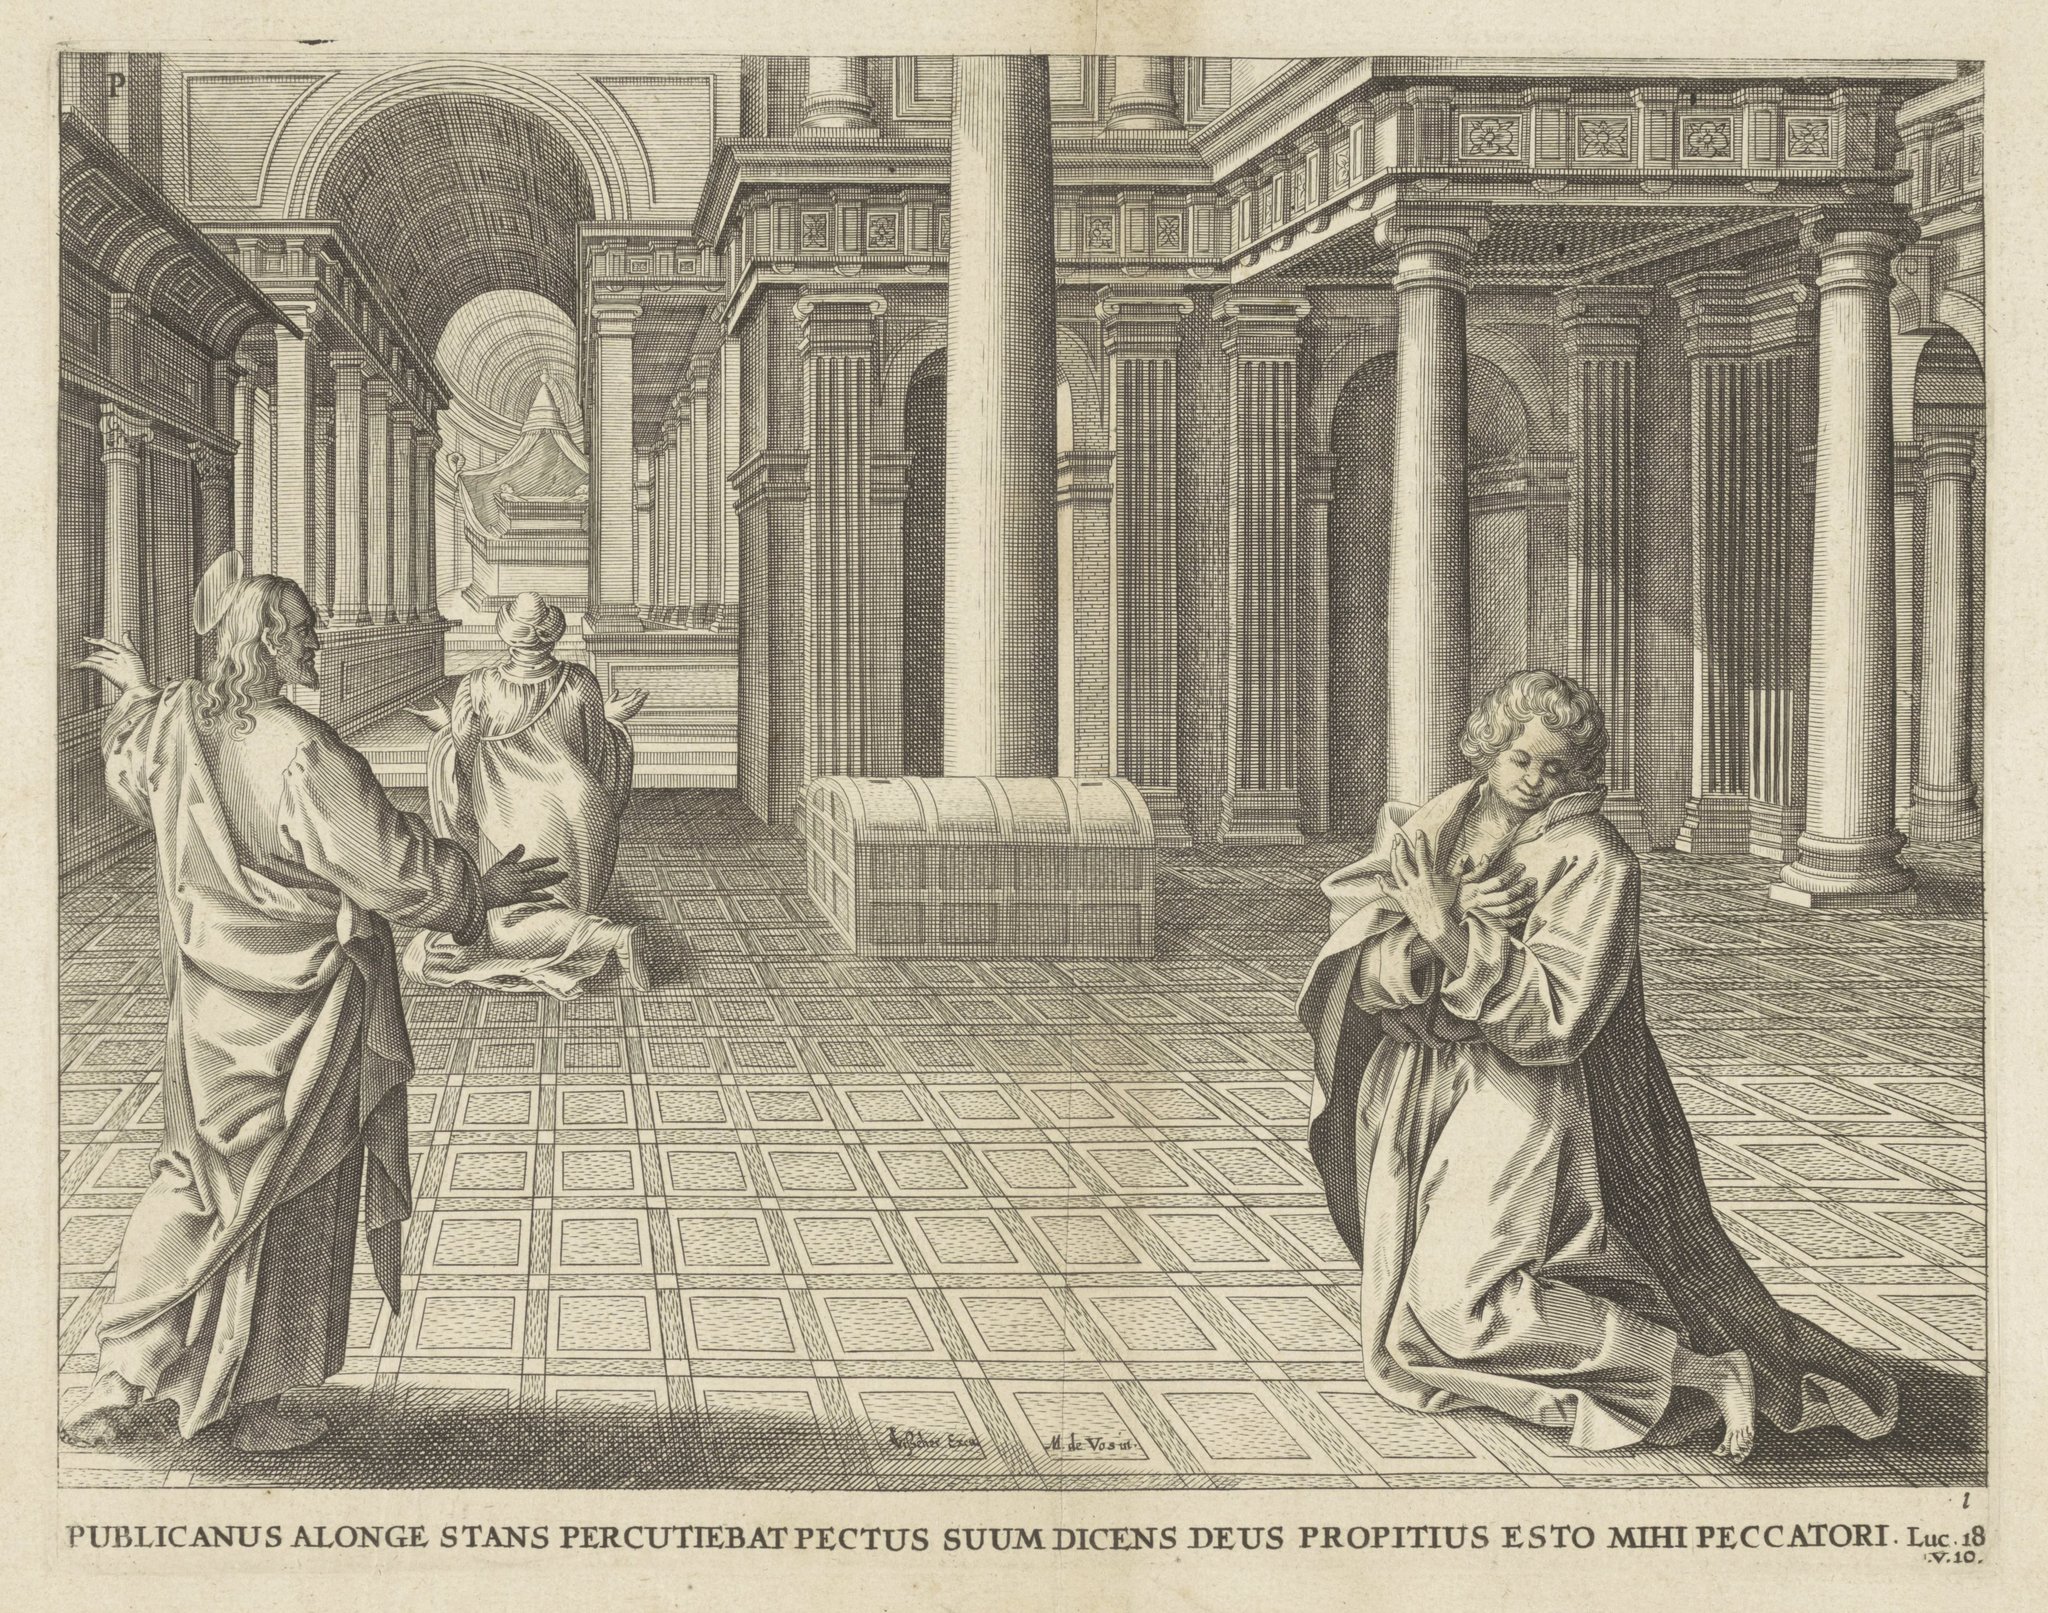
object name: print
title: Gelijkenis van de farizeeër en de tollenaar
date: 1643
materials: paper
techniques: engraving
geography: amsterdam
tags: the praying pharisee and the repentant publican in the temple (luke 18:10-14)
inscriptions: collector's mark: Lugt 2228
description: Prent gebruikt in: Theatrum biblicum : hoc est historiae sacrae veteris et novi testamenti tabulis aeneis expressae. Opus praesentatissimorum huius ac superioris seculi pictorum atque sculptorum, summo studio conquisitum et in lucem editum. Amsterdam: Claes Jansz. Visscher, 1643. De figuur van Christus is gekopieerd naar een prent van Adriaen Collaert naar ontwerp van Maerten de Vos. De tempel is gekopieerd naar een prent van de gebroeders van Doetechum naar ontwerp van Gerard van Groeningen.